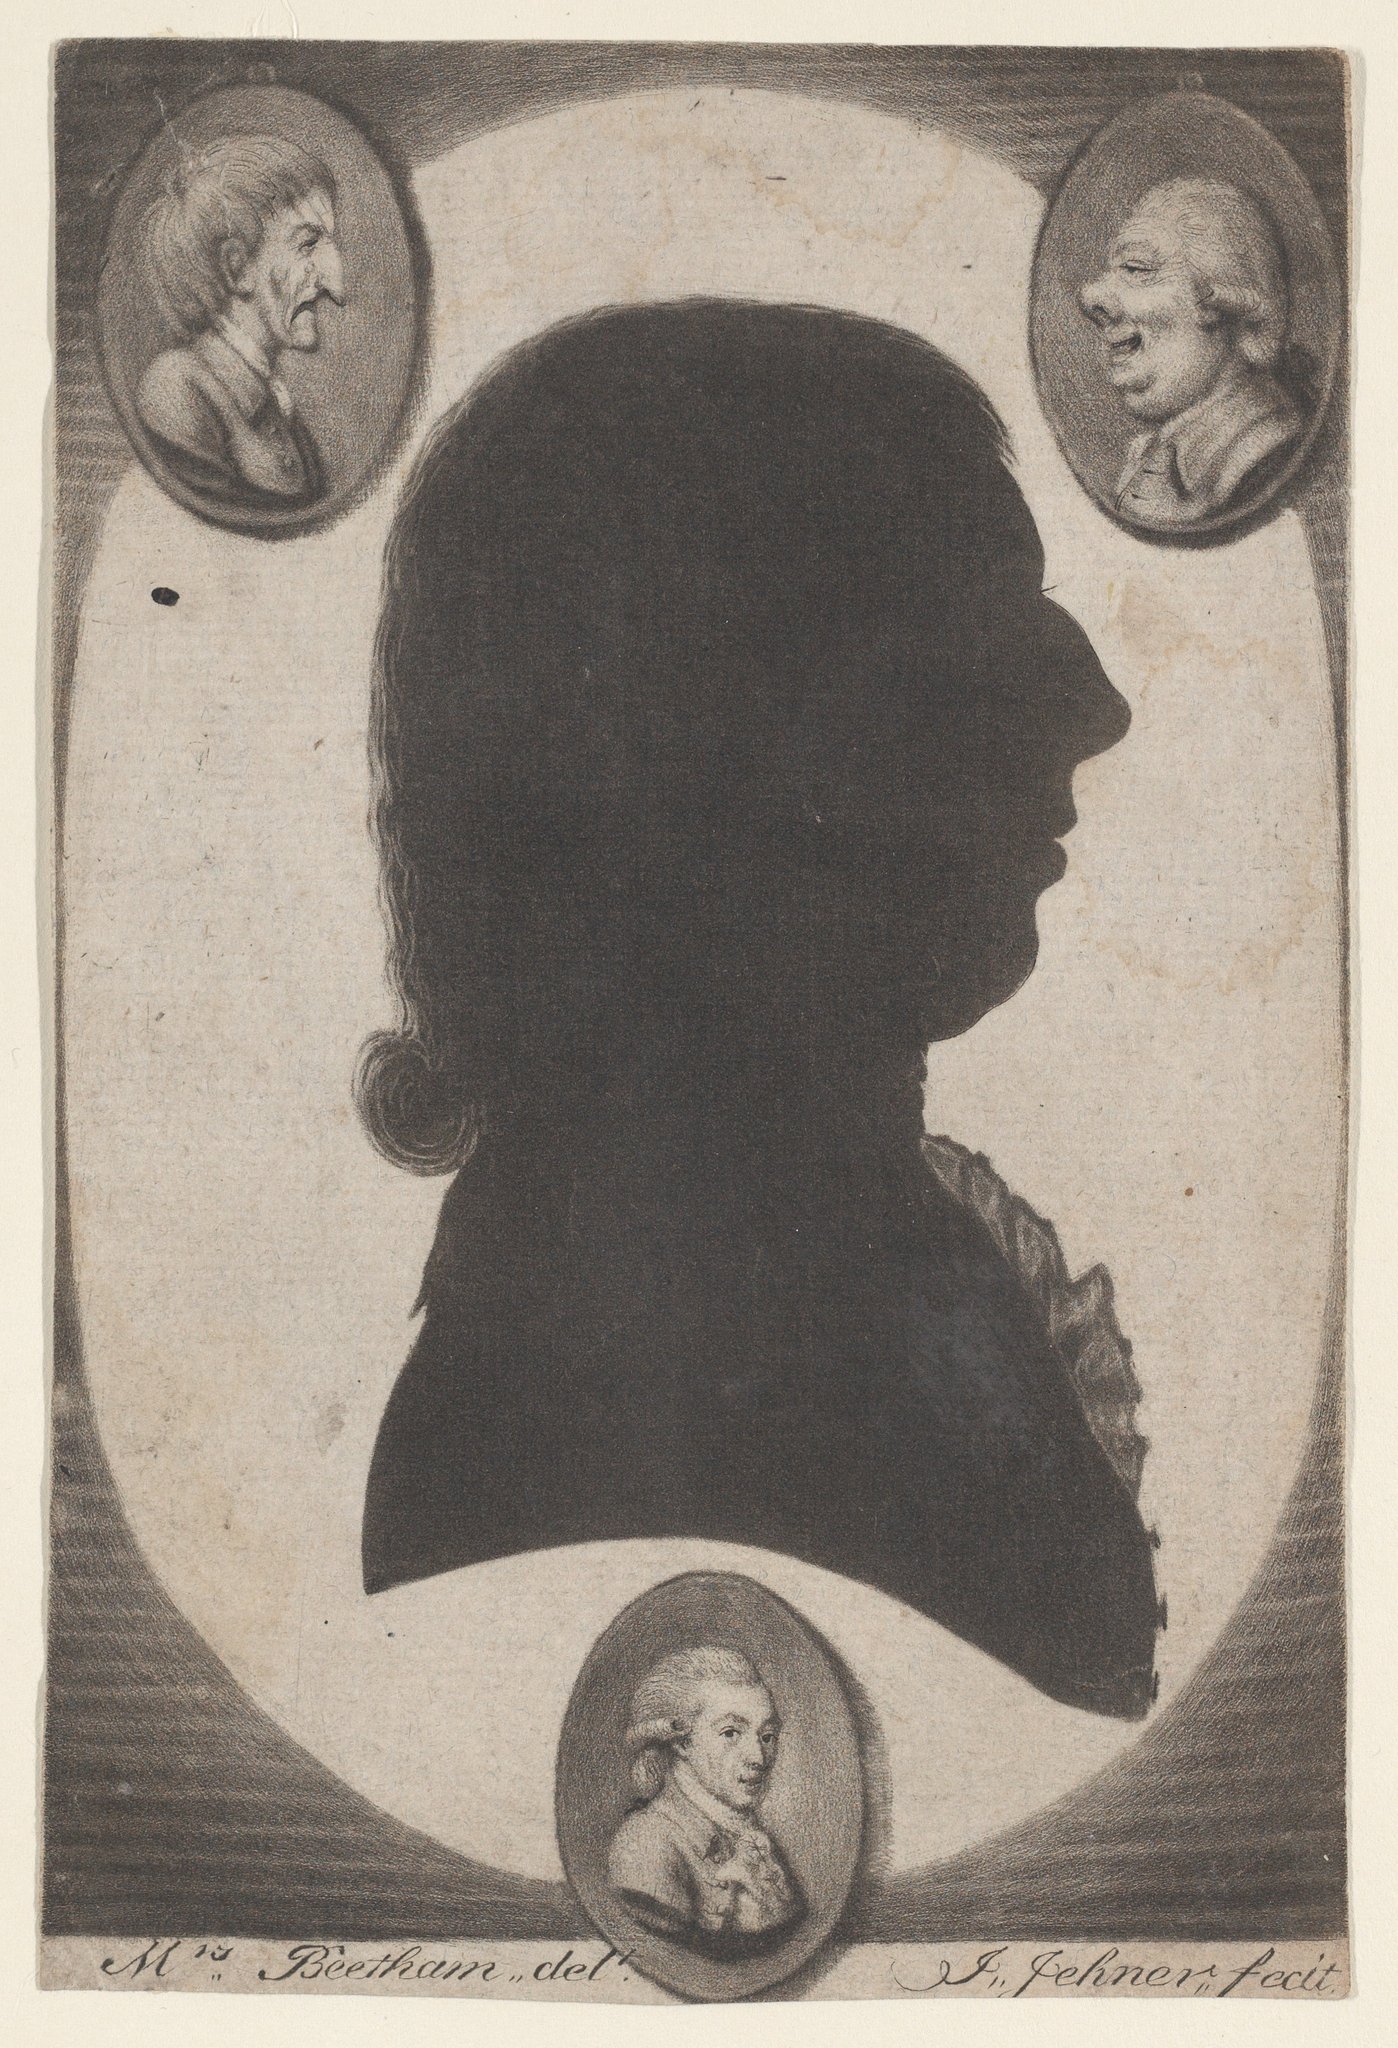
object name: print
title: Edward Beetham, bust in profile to right in an oval, with two caricature heads in small ovals in the upper corners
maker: isaac jehner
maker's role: artist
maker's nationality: british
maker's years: 1750-1818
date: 1770-1818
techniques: mezzotint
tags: men